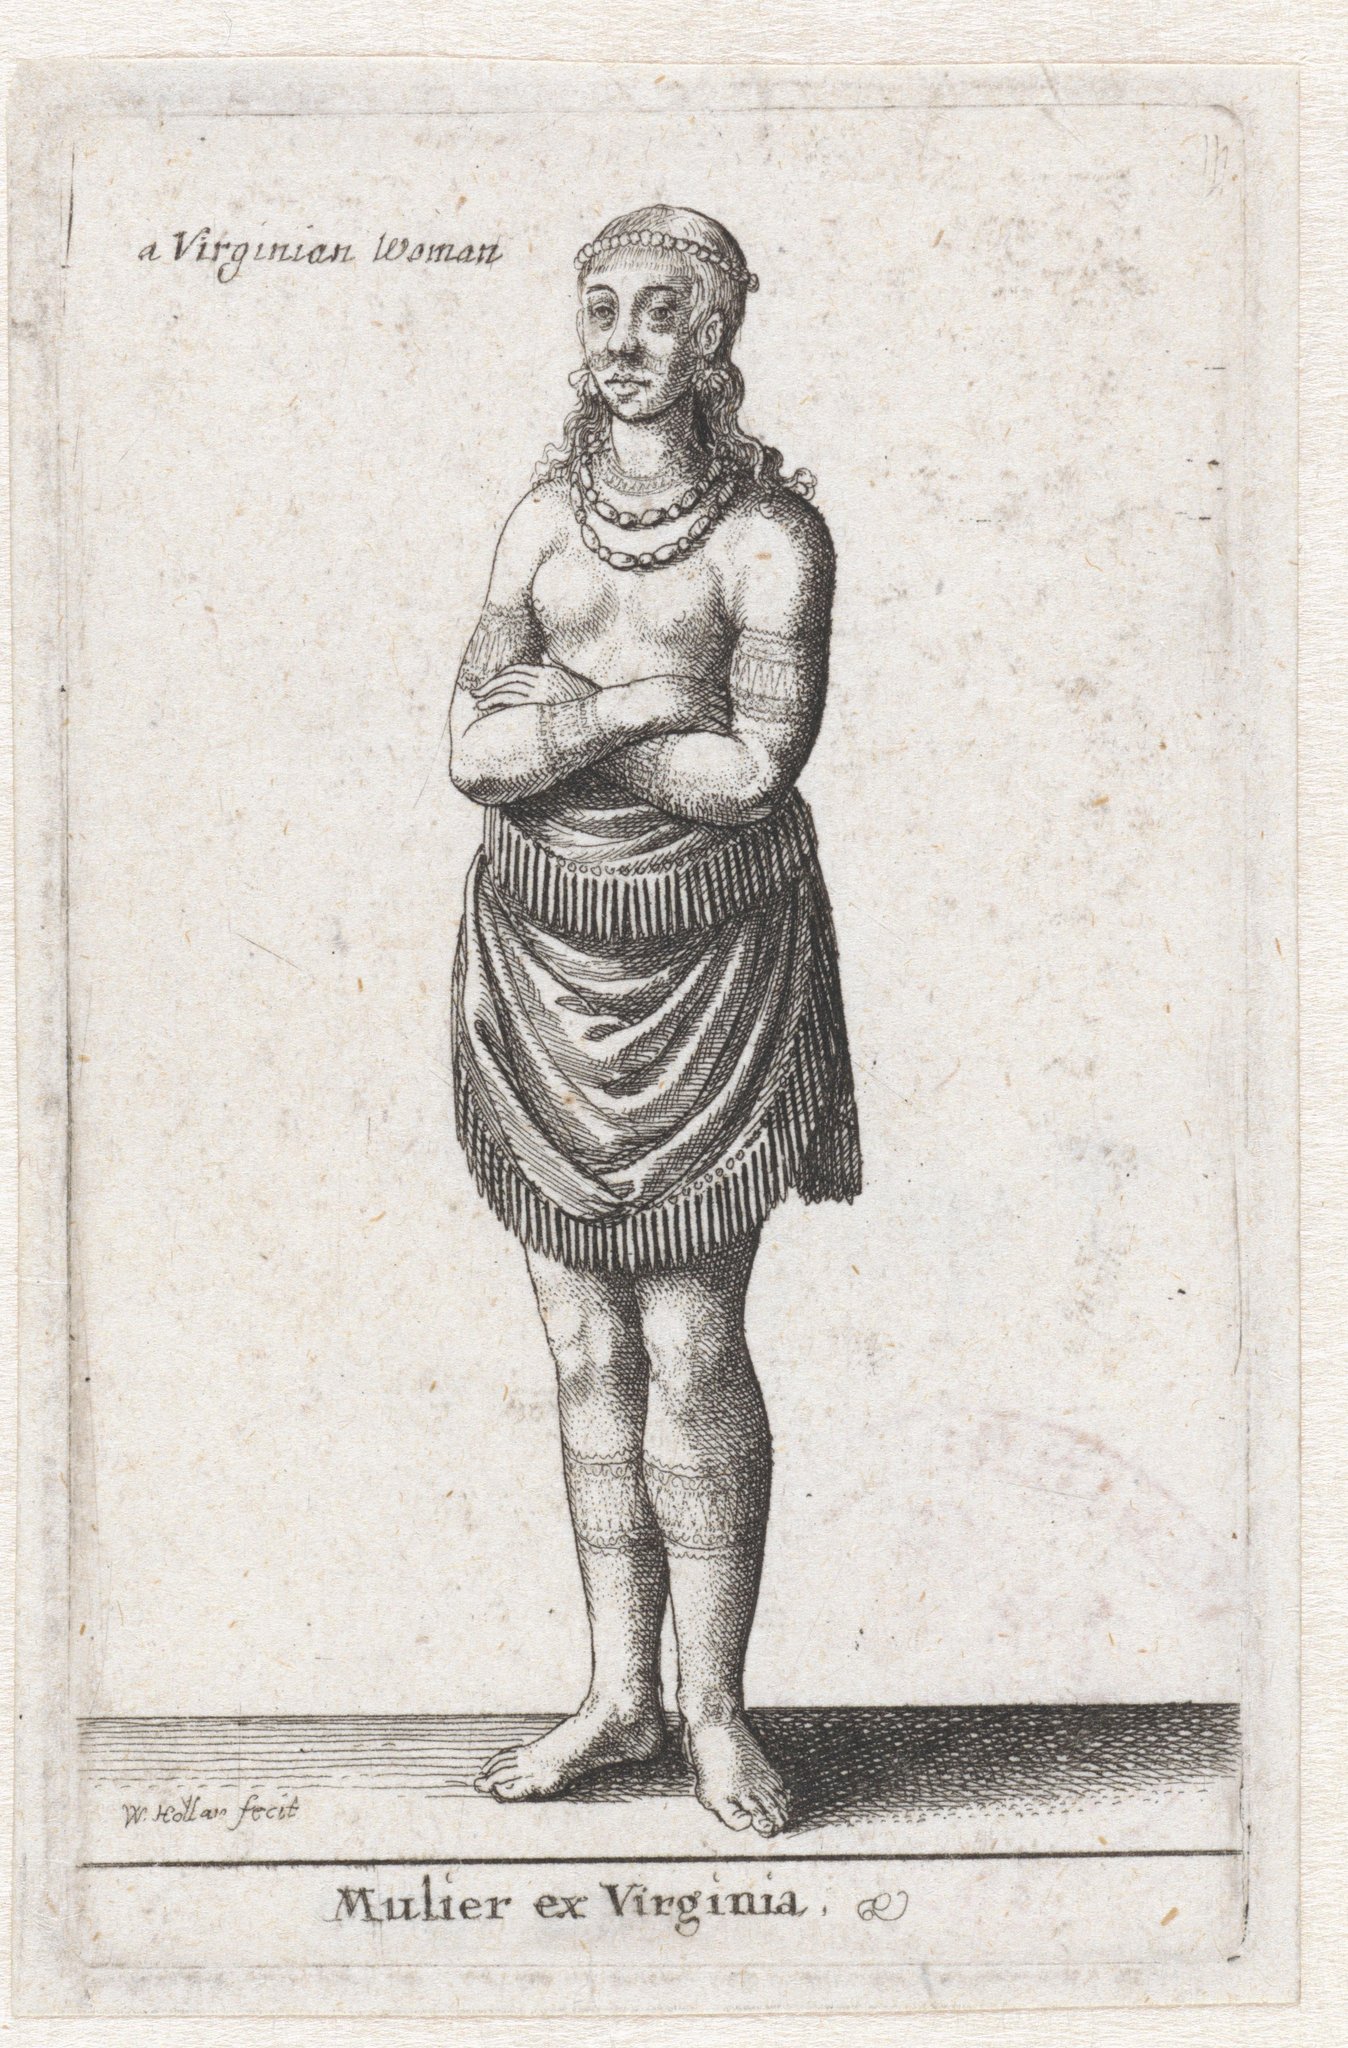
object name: costume print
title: Klederdracht van vrouwen uit verschillende landen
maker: wenceslaus hollar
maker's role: draughtsman, print maker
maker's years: 1607-1677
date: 1644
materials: paper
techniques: etching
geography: london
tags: indigenous peoples of north america (+ costume), indigenous peoples of north america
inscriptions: collector's mark: Lugt 240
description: Gemaakt naar een prent van Theodor de Bry - die gemaakt was naar een tekening van John White - uit De Bry's uitgaven van Thomas Harriots 'A briefe and true report of the new found land of Virgina'.